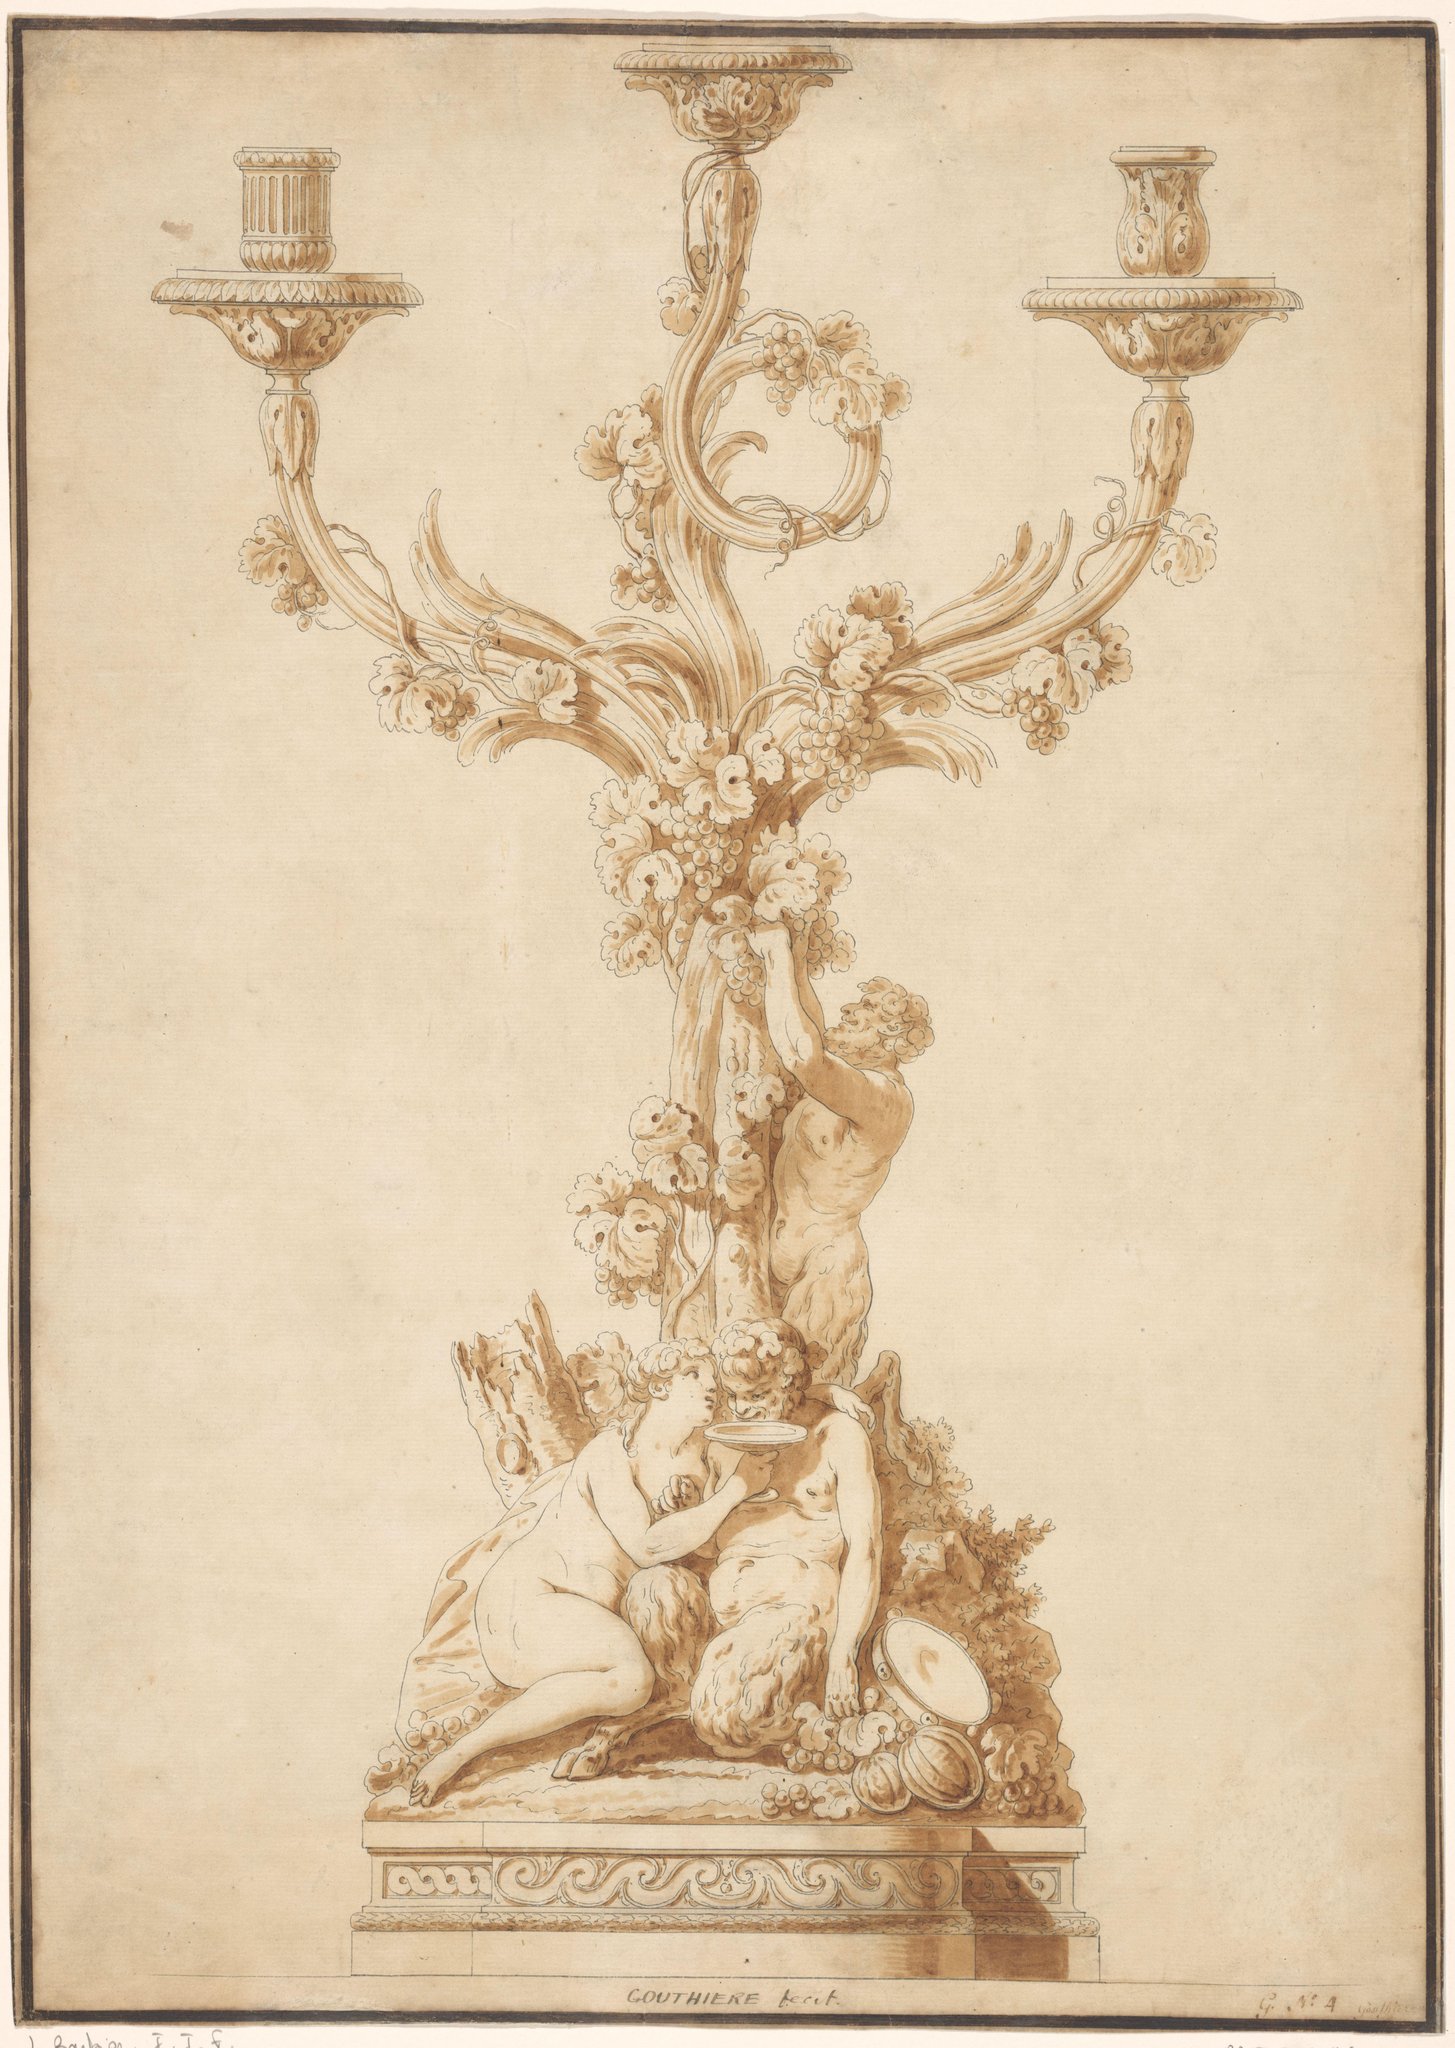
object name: design drawing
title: Verguld bronzen kandelaber met twee satyrs en een nymf, met varianten in de kaarsenhouders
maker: jean jacques françois le barbier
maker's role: draughtsman, painter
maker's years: 1738-1826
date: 1767-1770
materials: ink, paper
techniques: aquarelle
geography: paris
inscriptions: inscription: ‘G. No. 4 / Gouthiere’, inscription: ‘GOUTHIERE fecit’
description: Vermoedelijk heeft Le Barbier dit ontwerp voor Gouthière getekend, of een door Gouthière uitgevoerde kandelaar weergegeven.